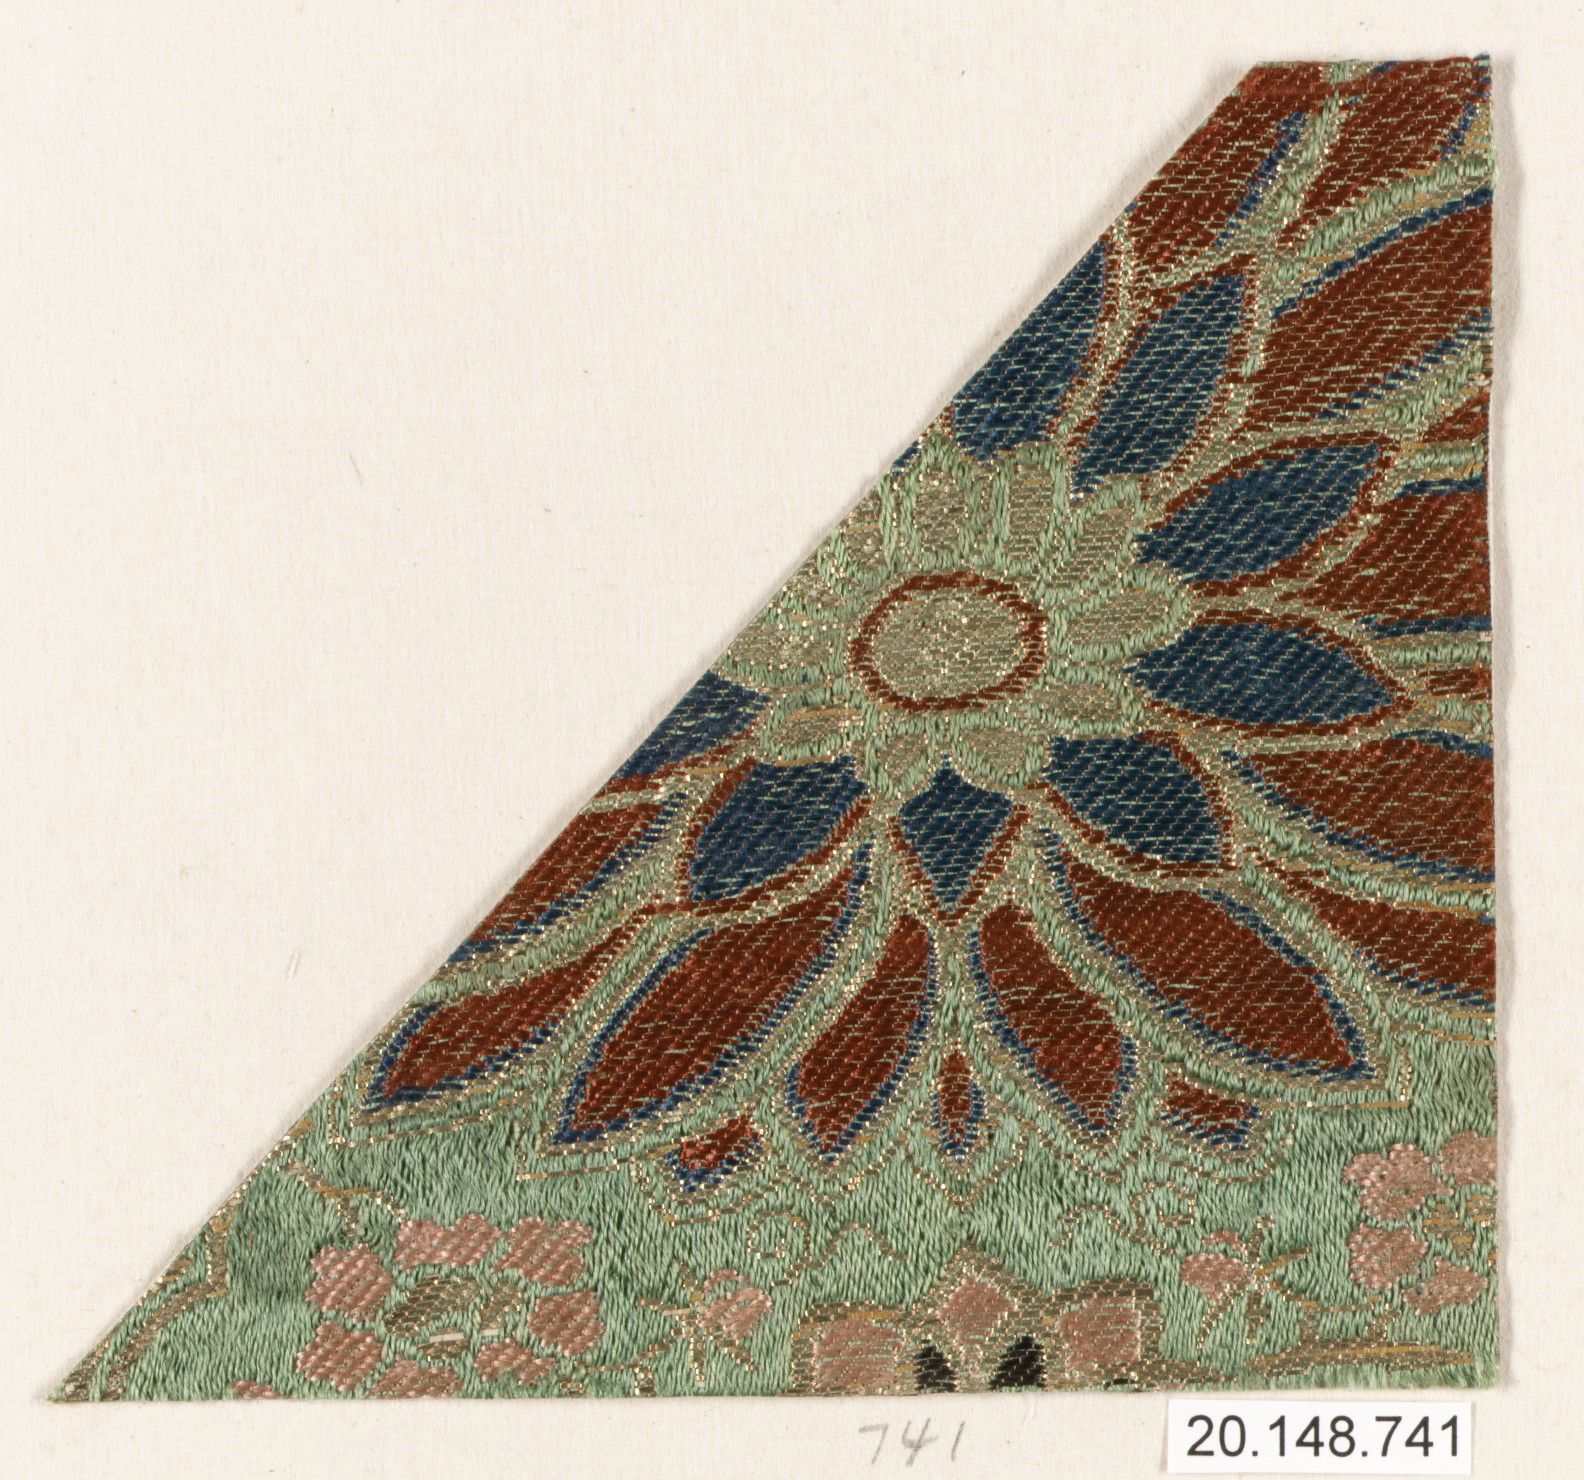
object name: piece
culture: japanese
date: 1601-1700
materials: silk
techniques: compound weave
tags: flowers